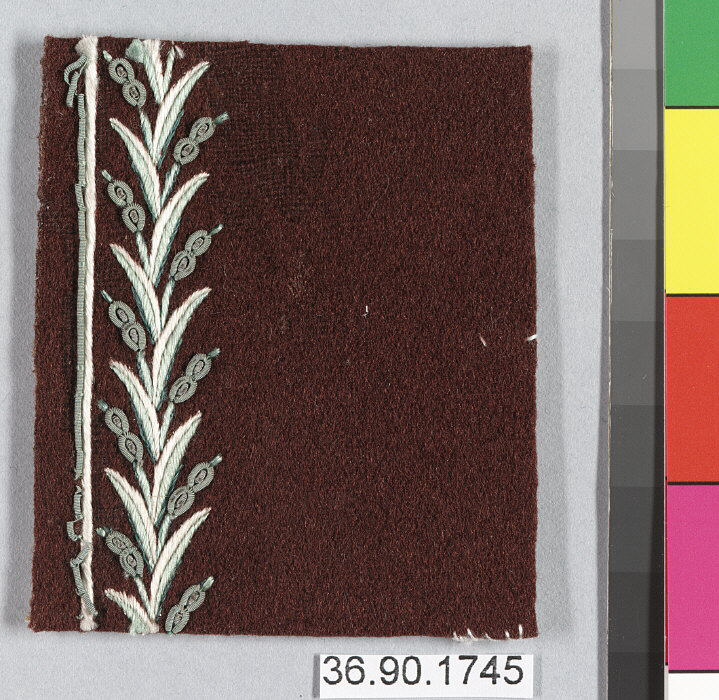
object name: sample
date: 1801-1833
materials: felt, metal thread, silk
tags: plants